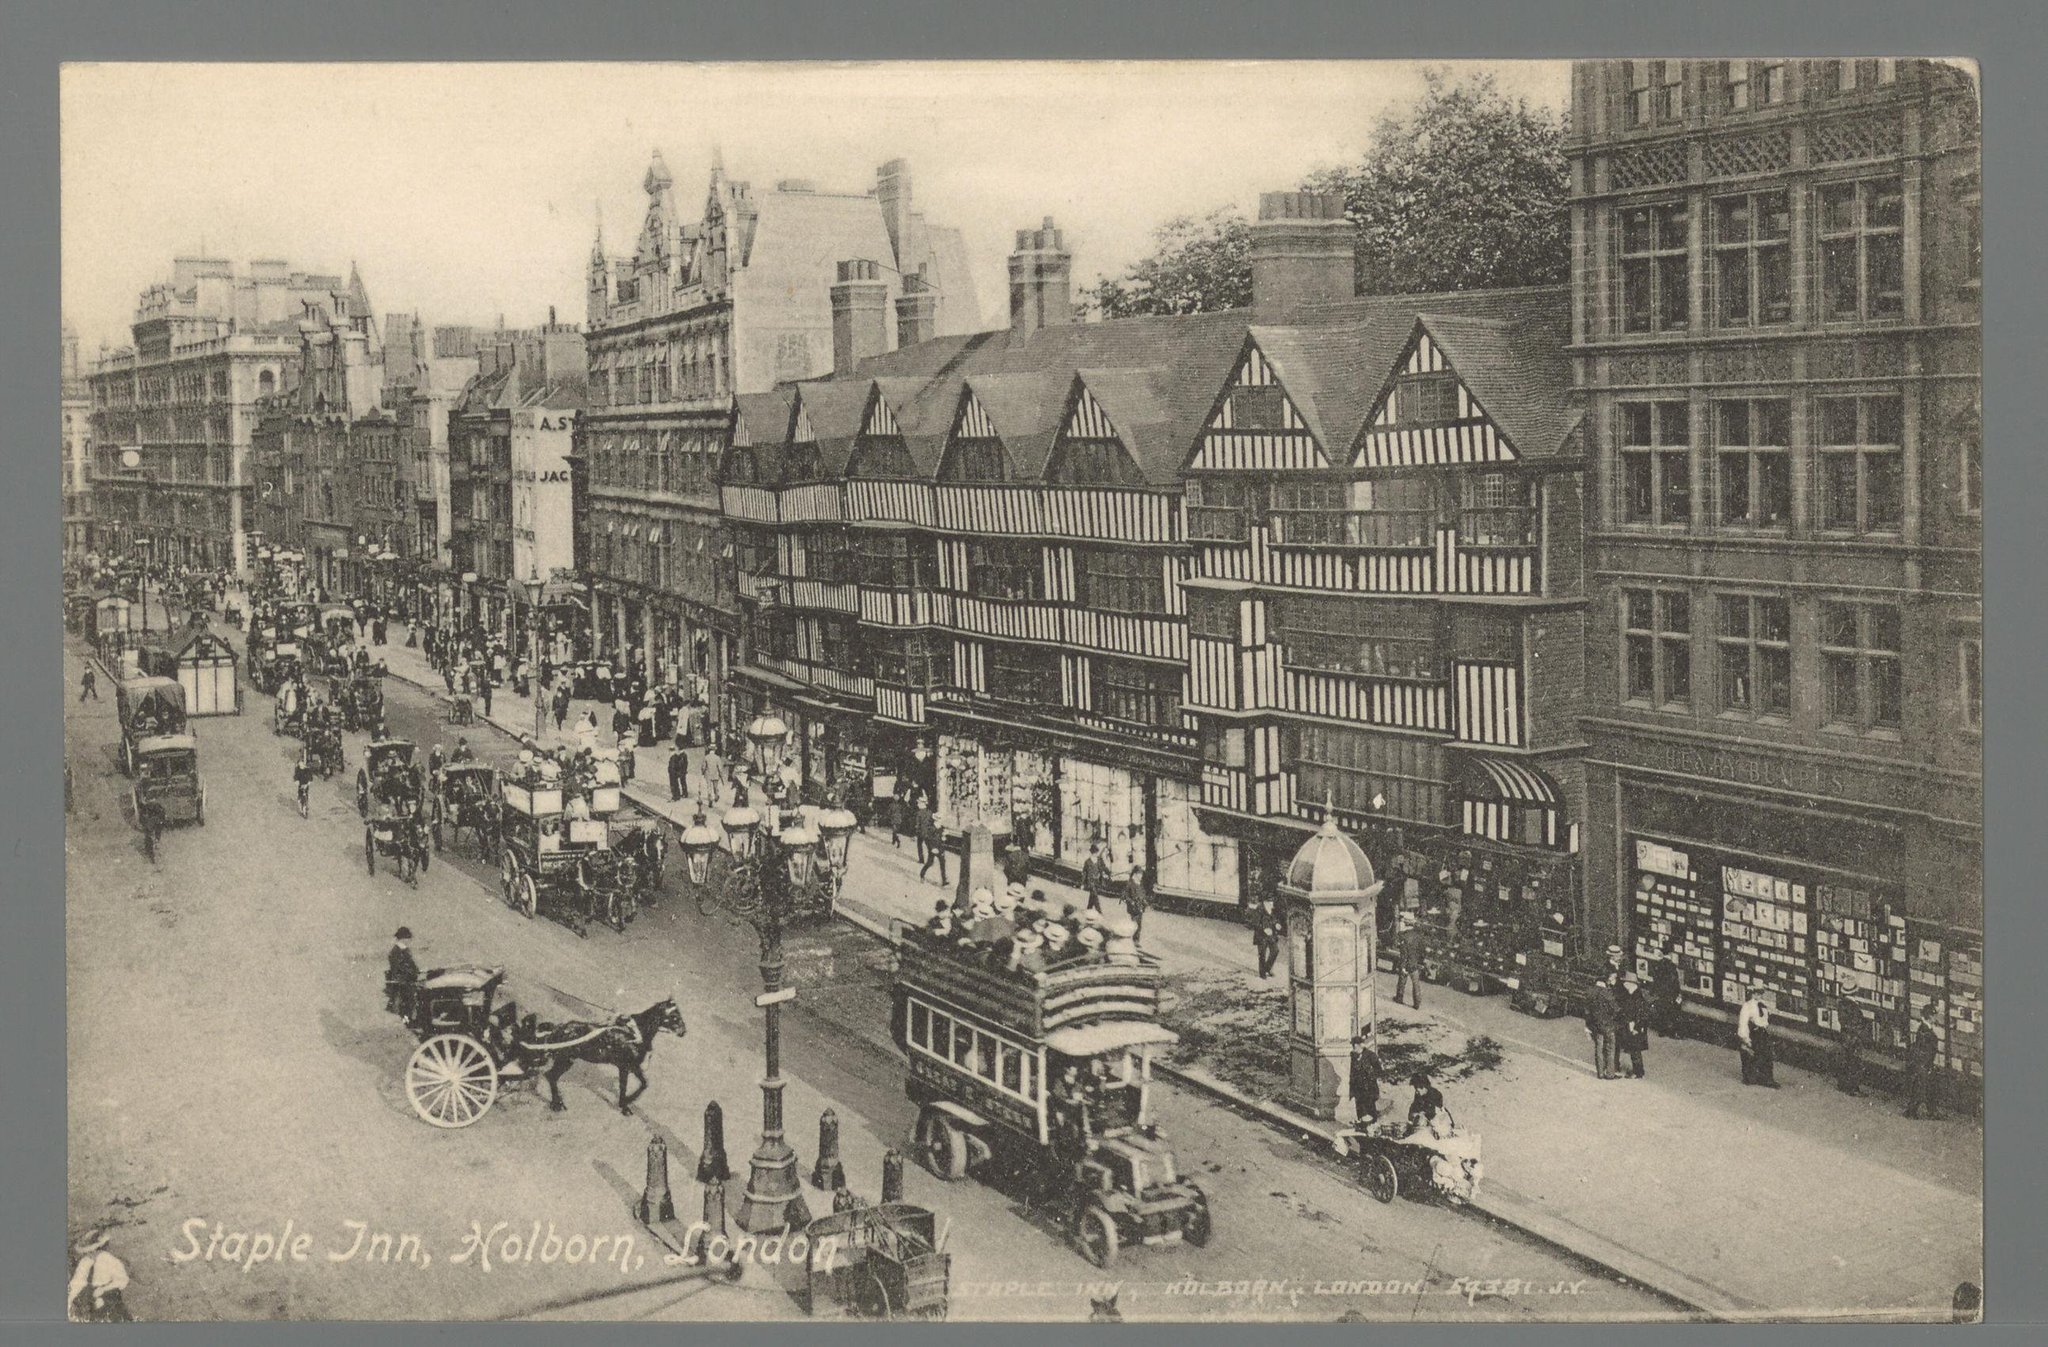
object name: photomechanical print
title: Staple Inn, Holborn, London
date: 1902-1930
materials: cardboard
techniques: photograph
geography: london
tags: diligence, omnibus, horse-tram, automobile, street, hotel, hostelry, inn, london